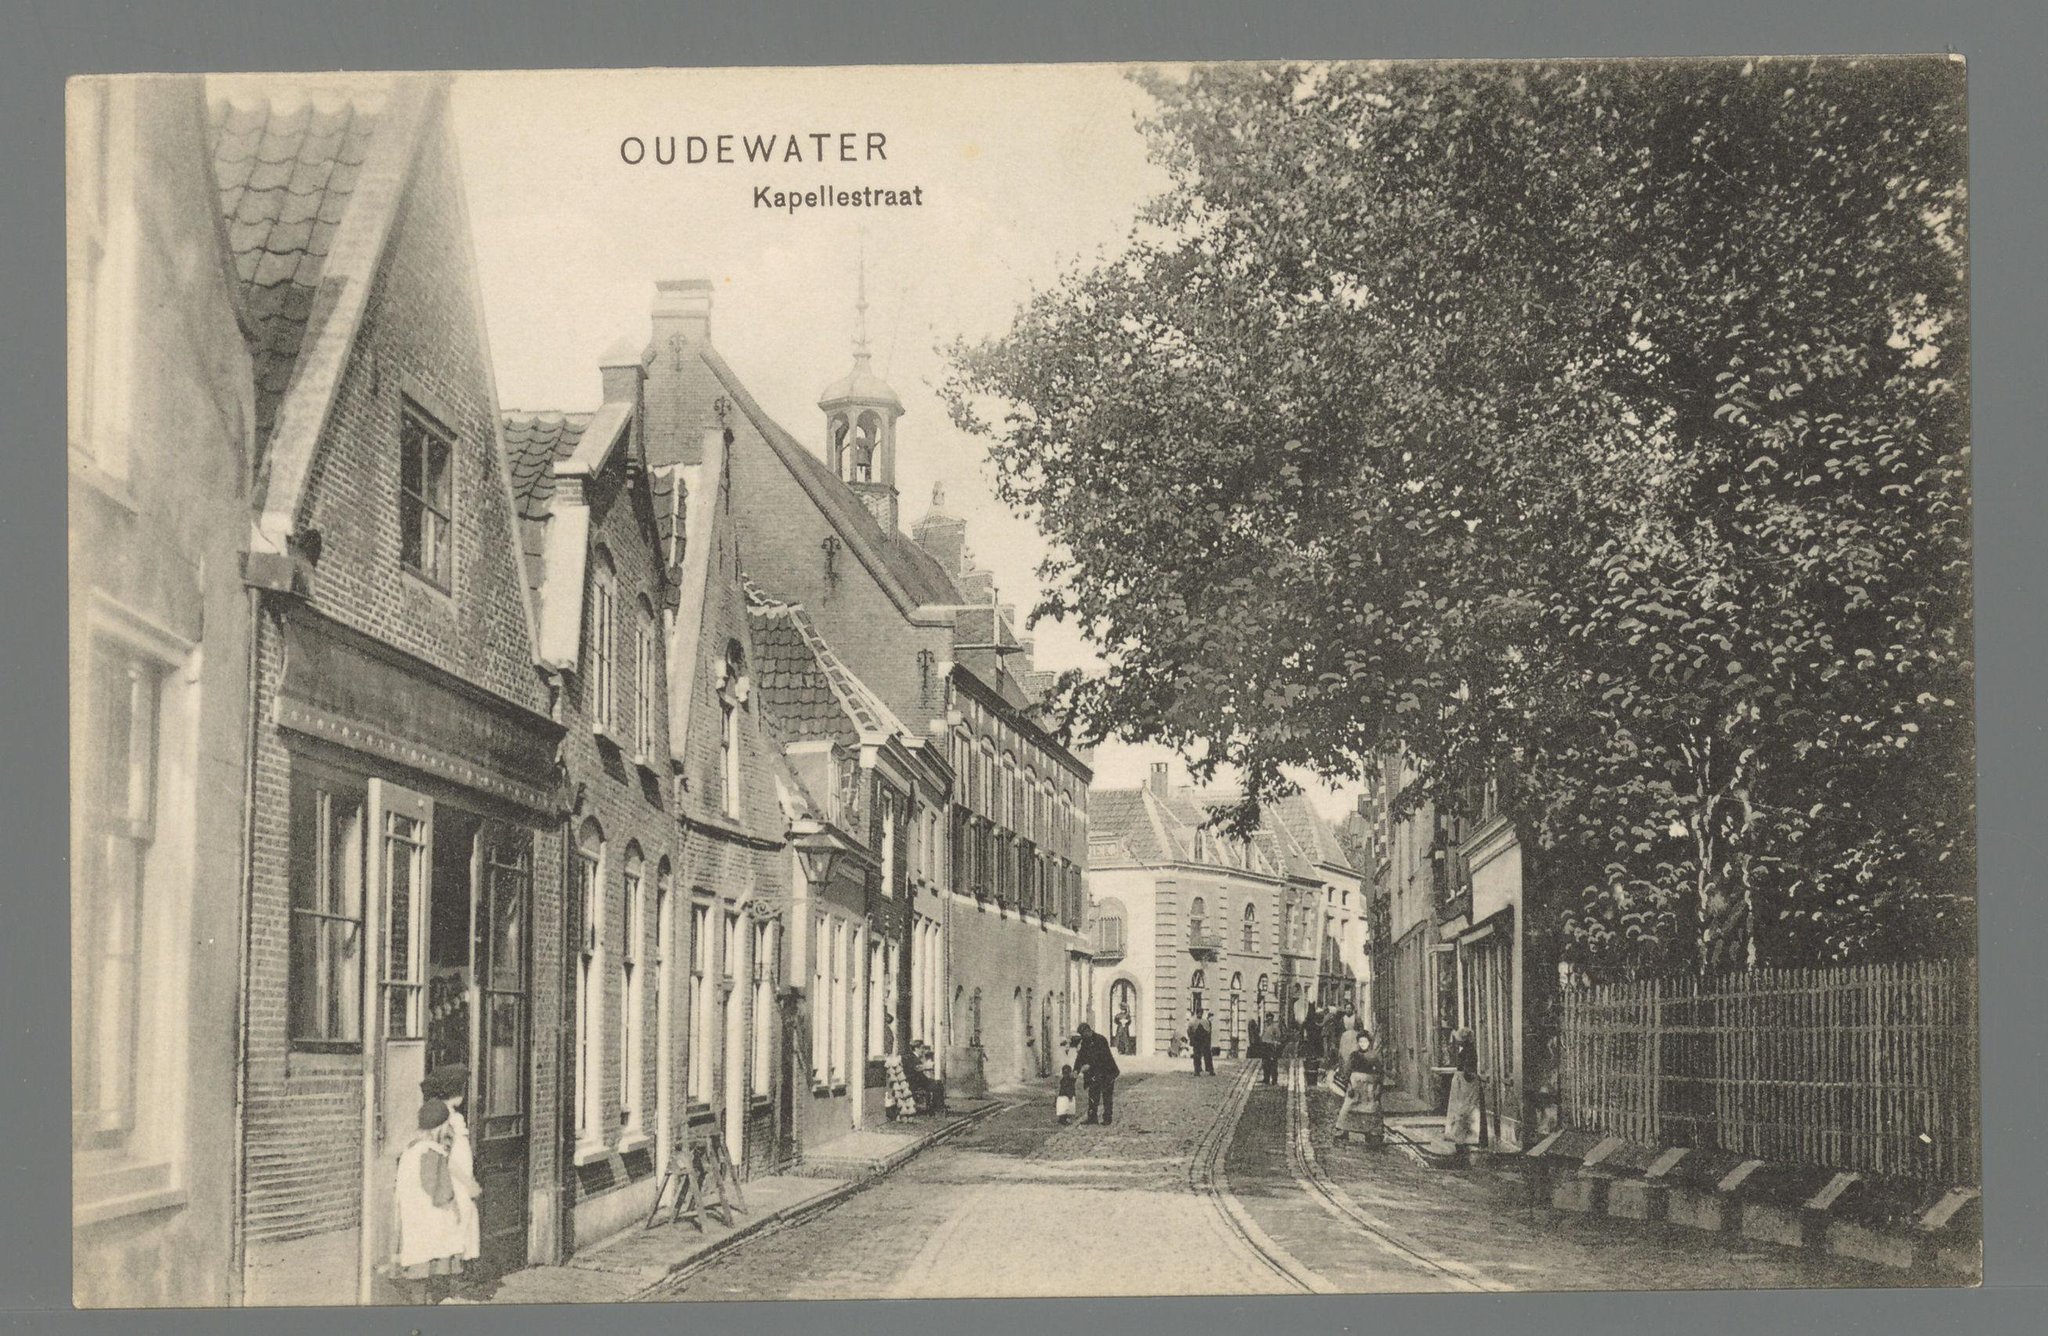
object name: photomechanical print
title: Oudewater, Kapellestraat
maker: Anonymous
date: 1905-1930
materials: cardboard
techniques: photograph, writing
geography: oudewater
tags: street